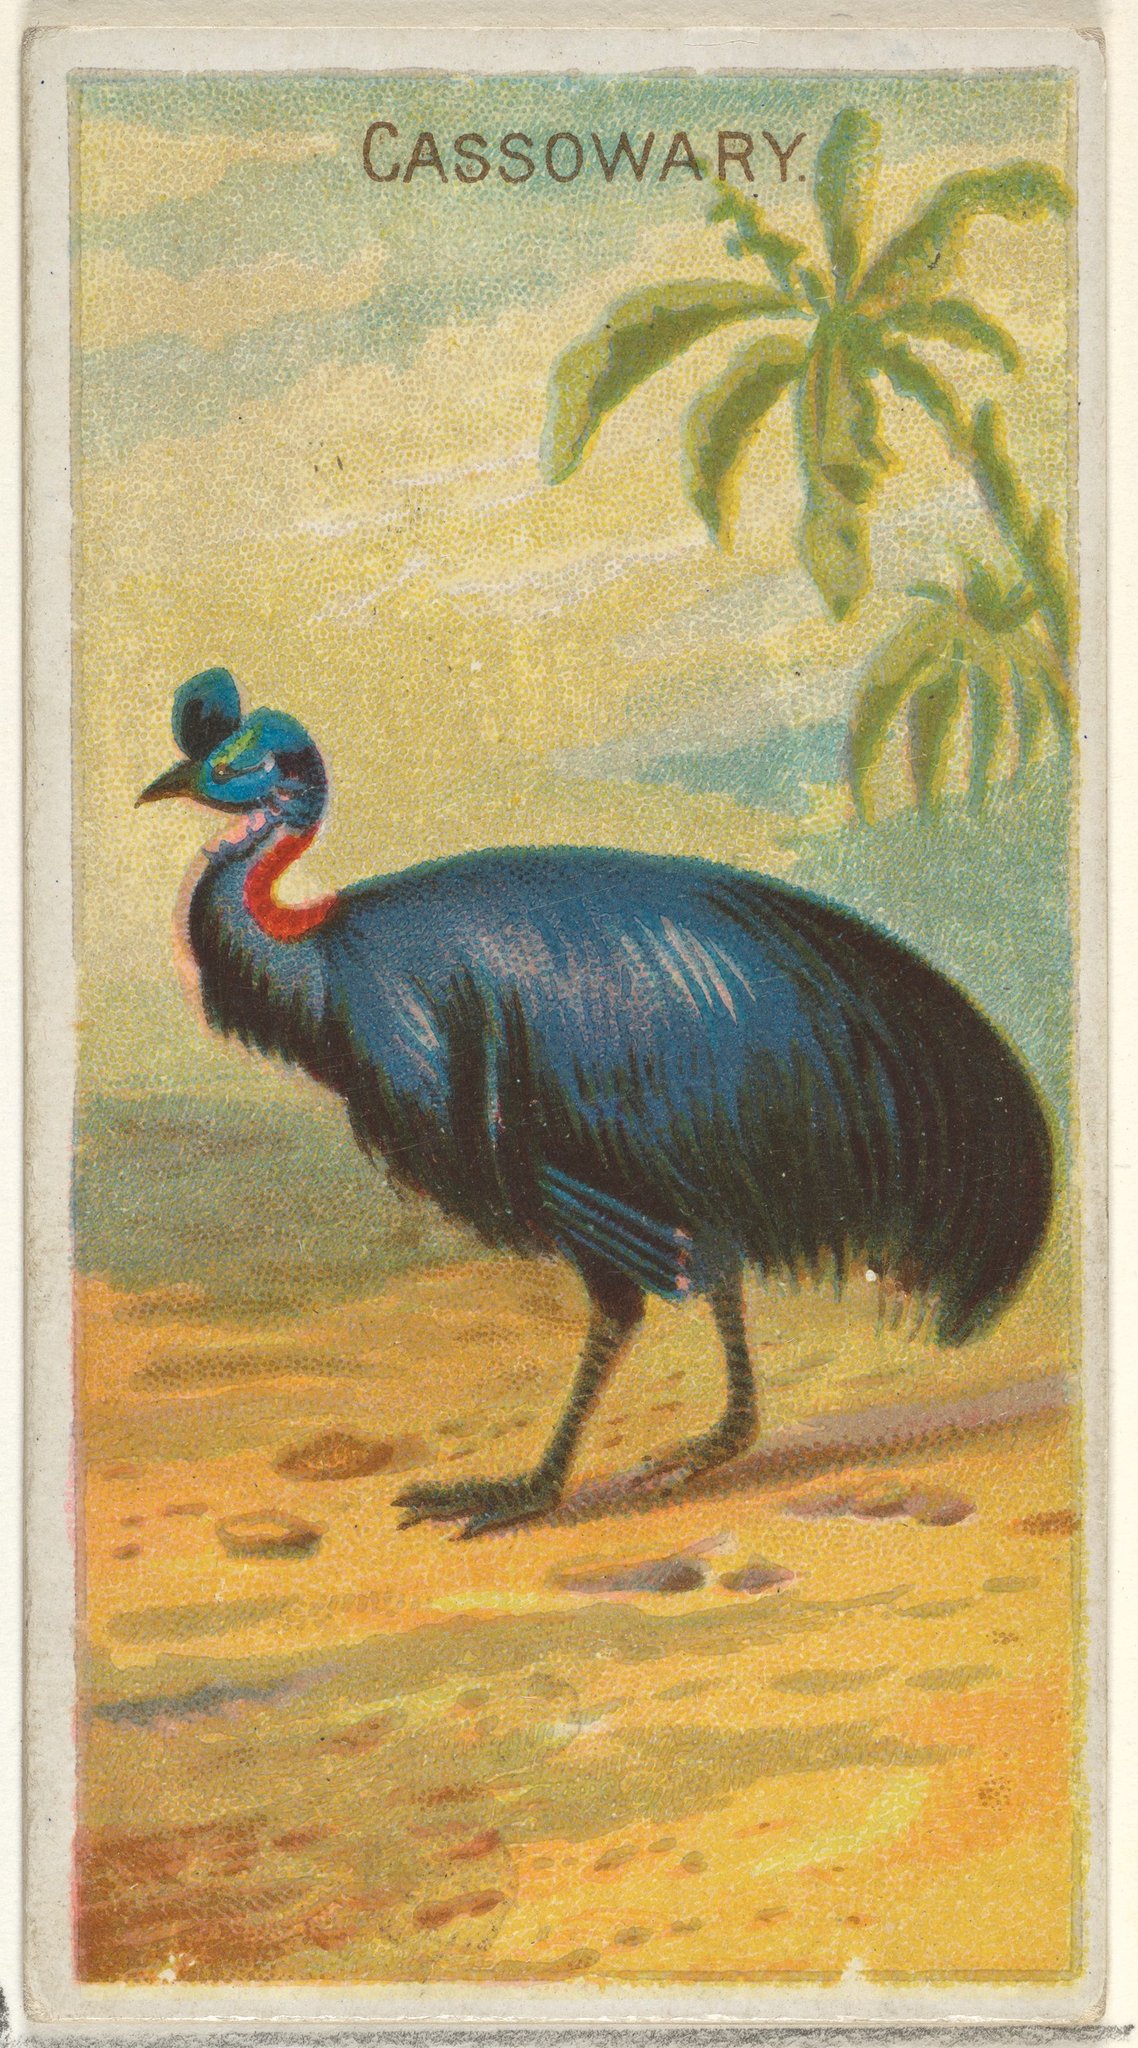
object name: print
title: Cassowary, from the Birds of the Tropics series (N5) for Allen & Ginter Cigarettes Brands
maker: allen & ginter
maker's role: publisher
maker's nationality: american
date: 1889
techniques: color lithograph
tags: birds